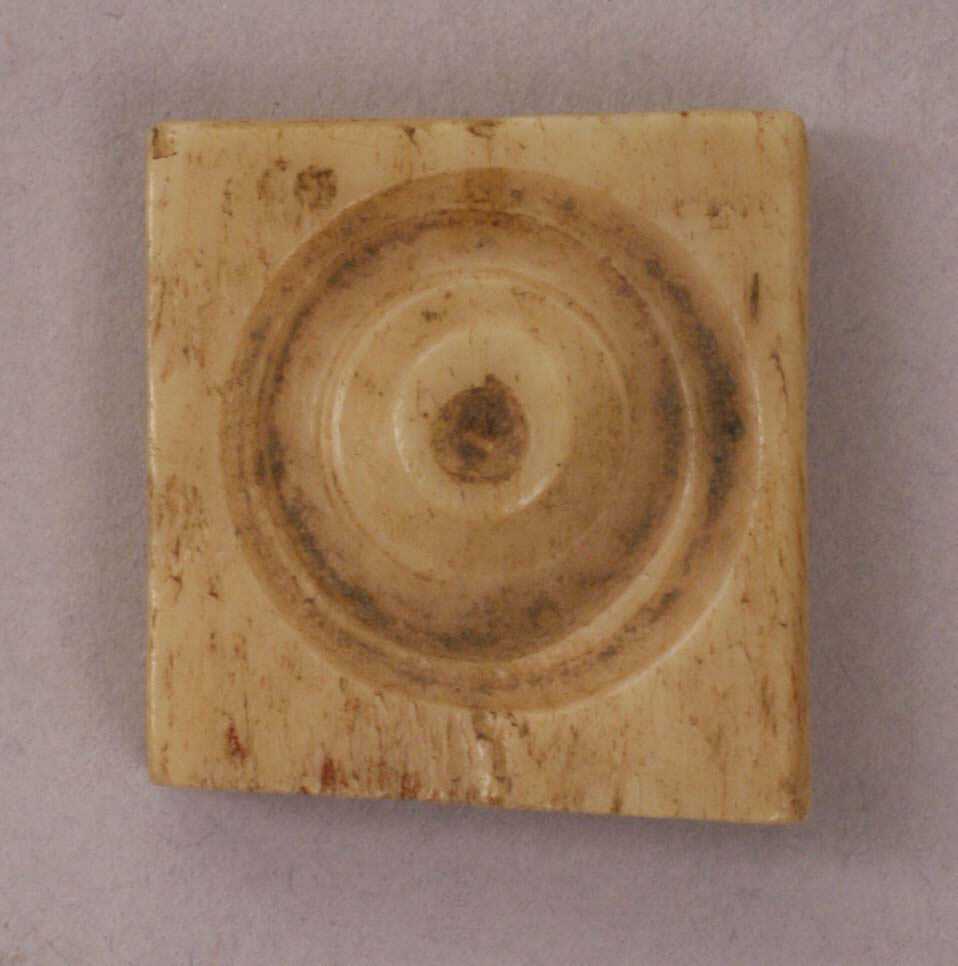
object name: counter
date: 30 BCE-364 CE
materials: bone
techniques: carving, incising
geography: egypt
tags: games